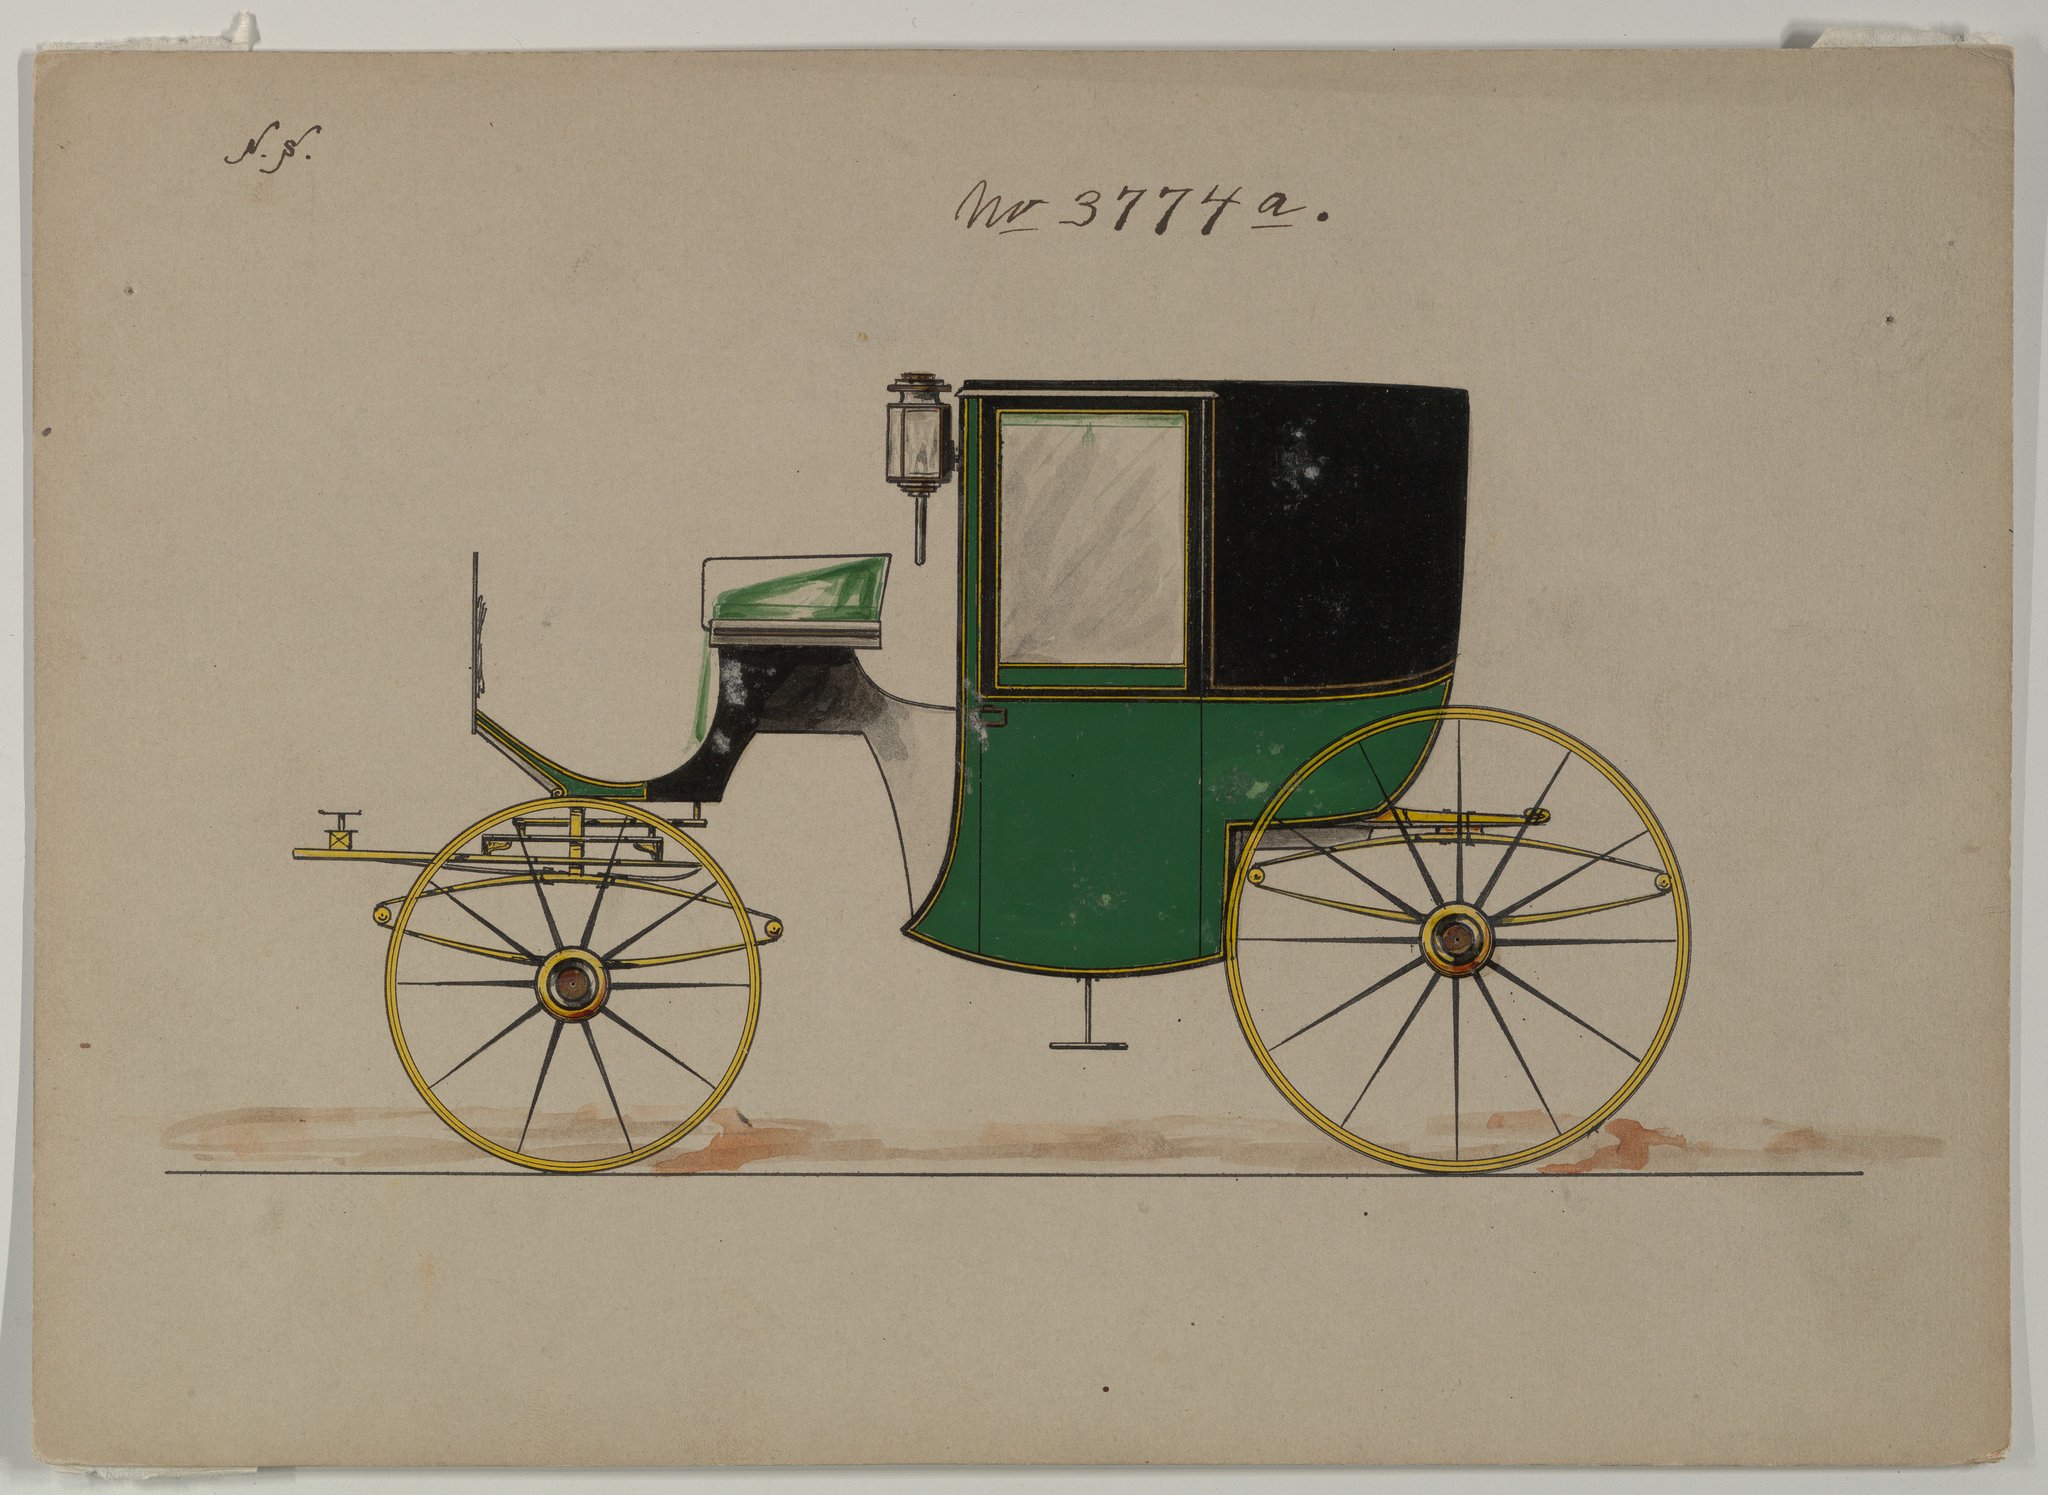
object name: drawing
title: Brougham #3774a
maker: brewster & co.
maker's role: manufacturer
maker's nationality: american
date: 1882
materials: gouache, gum arabic, ink, watercolor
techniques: pen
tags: carriages